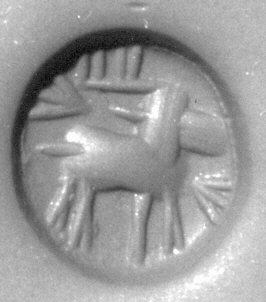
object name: stamp seal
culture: sasanian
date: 201-700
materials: stone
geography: iran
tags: animals